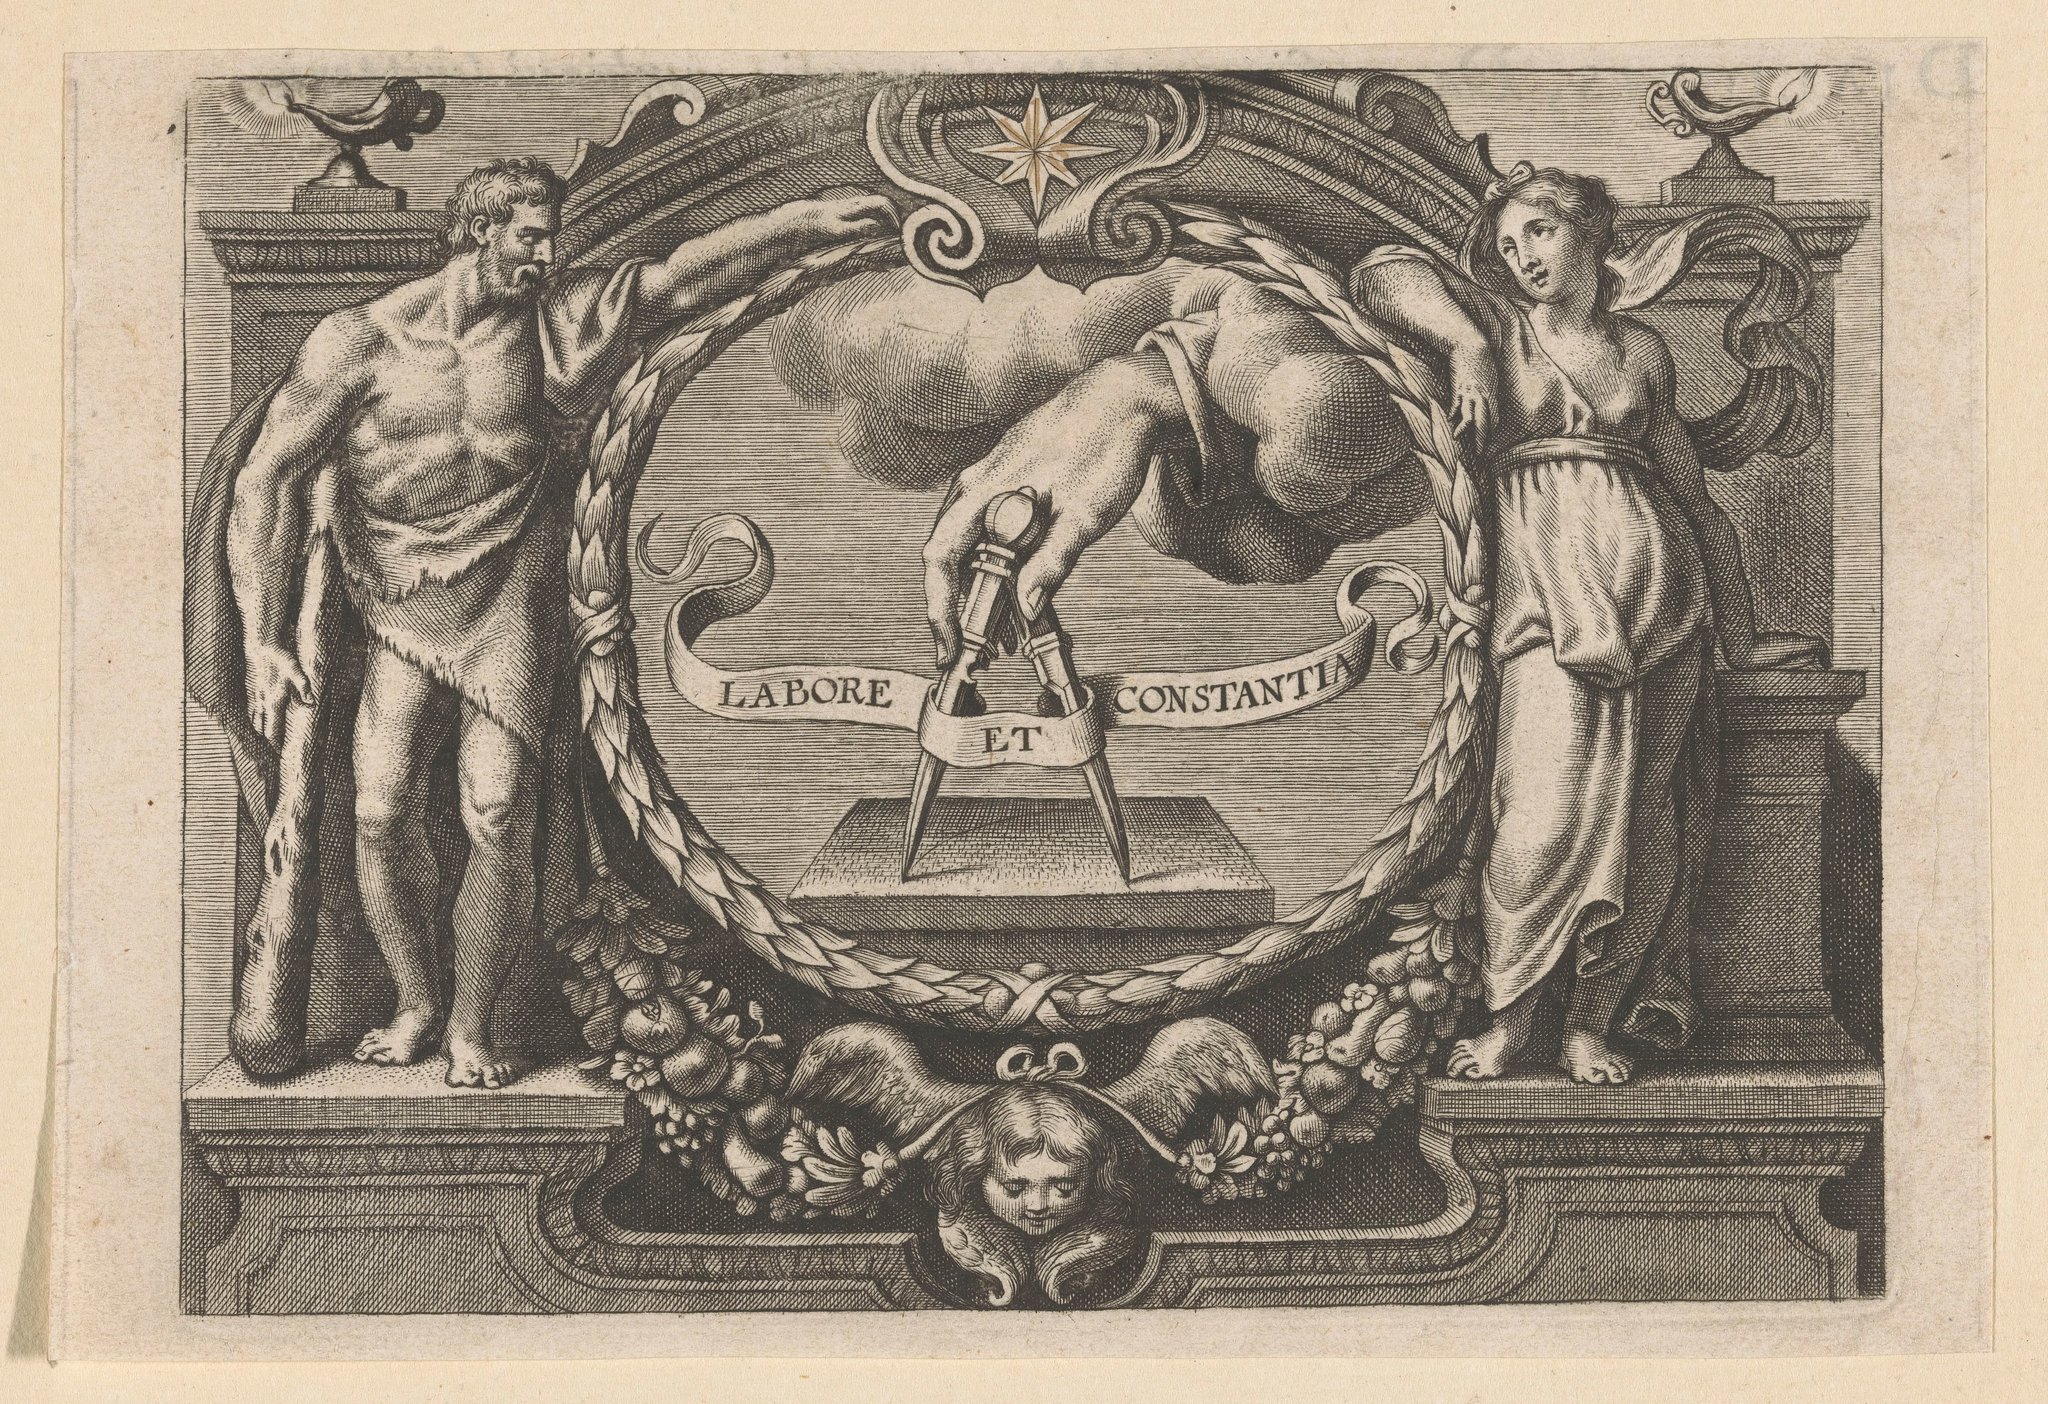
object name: printer's mark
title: Drukkersmerk voor de Officina Plantiniana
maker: cornelis galle (i)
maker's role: print maker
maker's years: 1576-1650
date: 1636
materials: paper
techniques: engraving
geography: southern netherlands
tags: compasses, device (trade-mark of printer or publisher)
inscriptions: collector's mark: Lugt 240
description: Drukkersmerk voor de drukkerij Plantijn-Moretus in Antwerpen. In het midden een hand met een passer, een verwijzing naar het uithangbord van de drukkerij "De gulden passer". Op een spreukband het motto van Christoffel Plantijn: Labore et constantia.